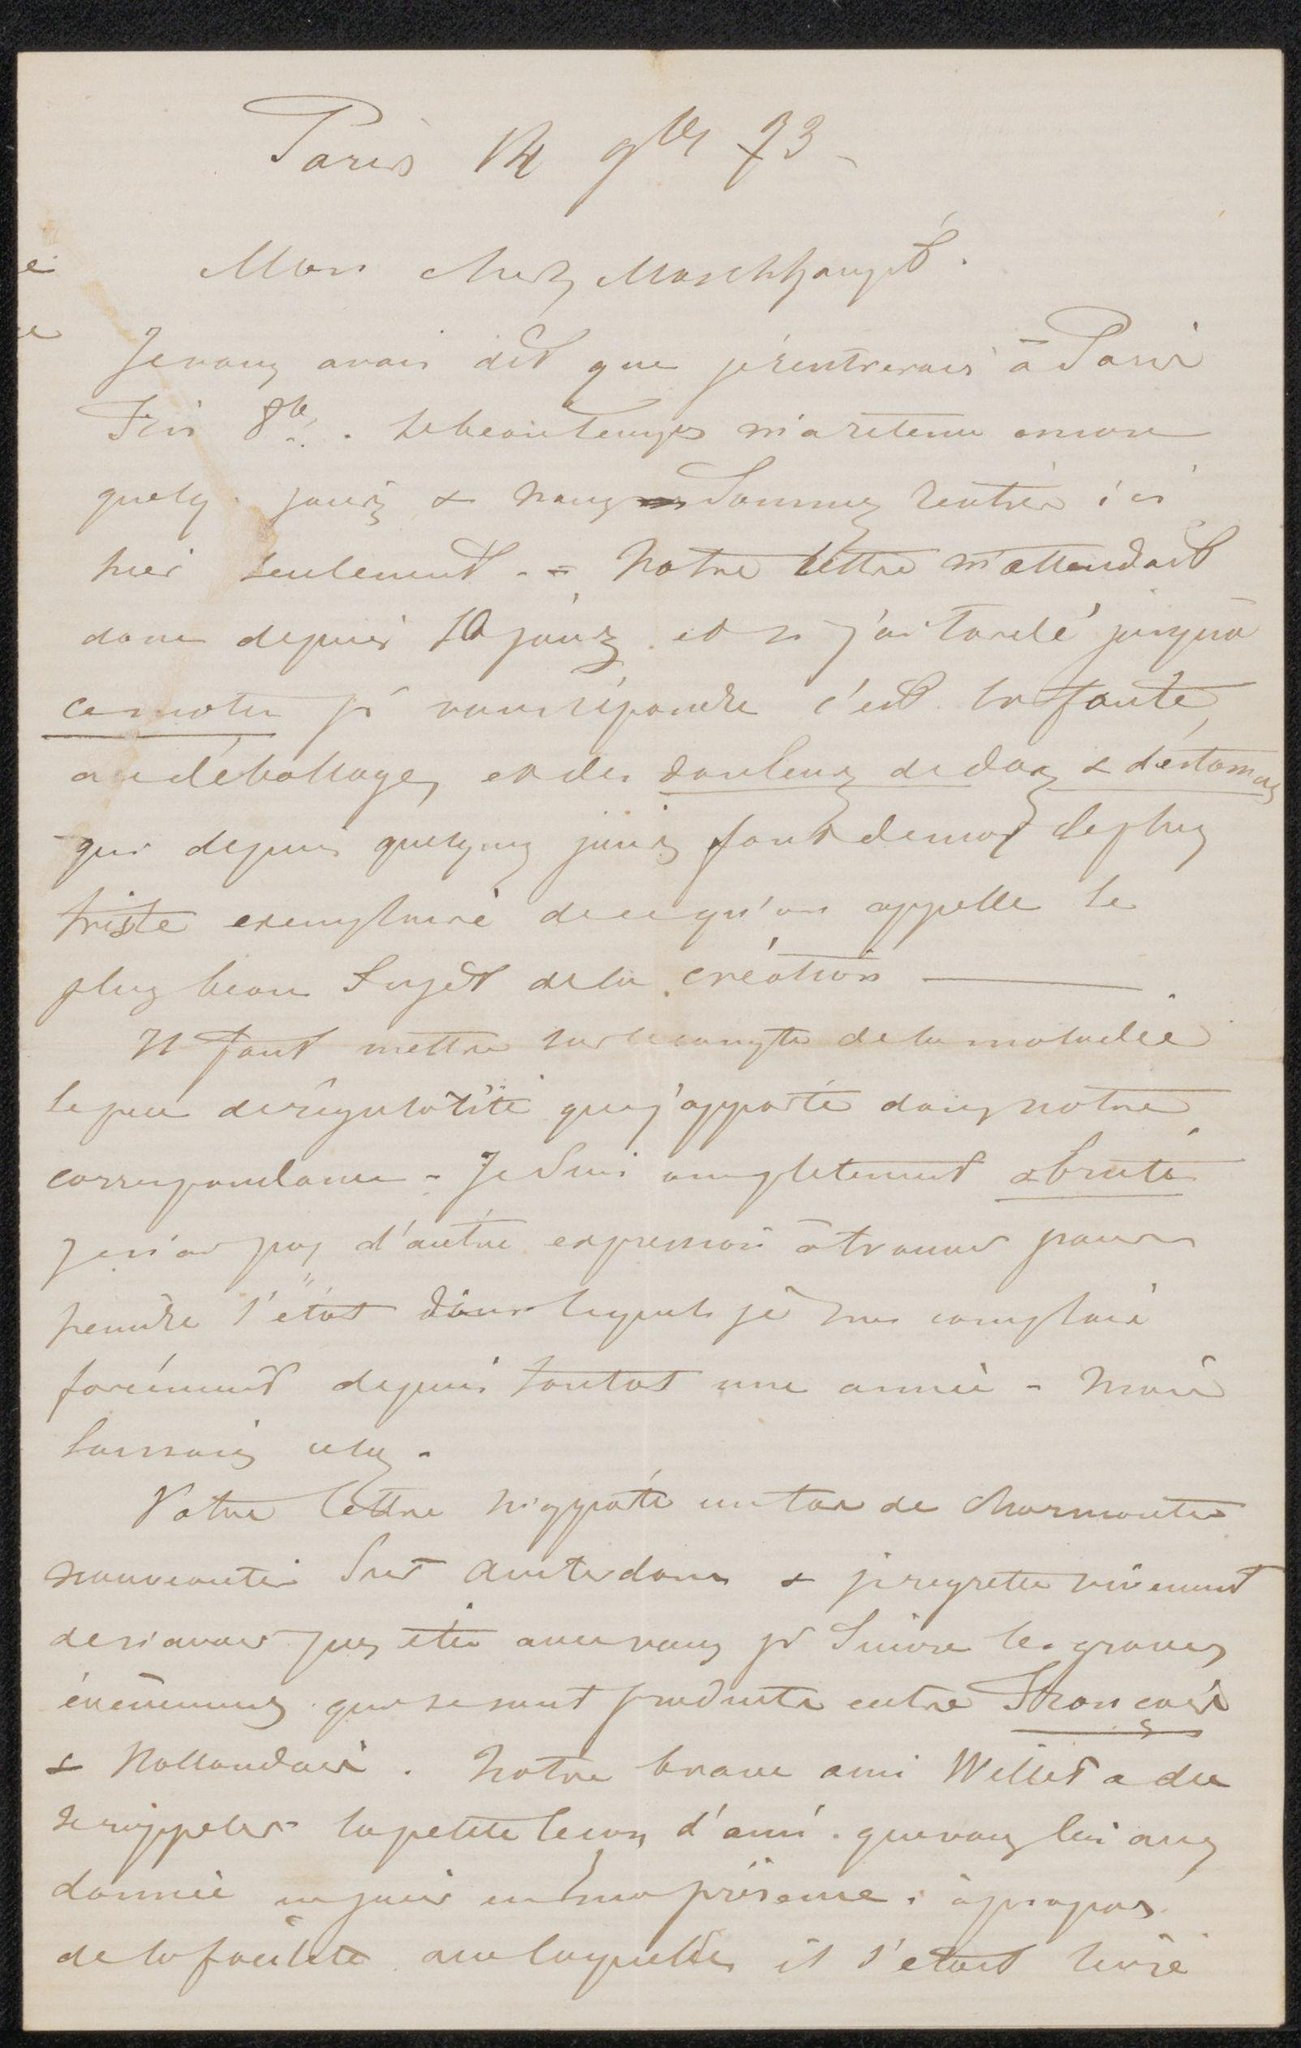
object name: letter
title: Brief aan Jan Hendrik Maschaupt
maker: adolphe mouilleron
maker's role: draughtsman, print maker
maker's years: 1820-1881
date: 1873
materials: ink, paper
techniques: pen, writing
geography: paris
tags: andrzej graaf mniszech, jan hendrik maschaupt, haarlem, frans hals, leiden, amsterdam, painter, print maker, draughtsman, rembrandt van rijn, paris, daniël franken dzn., charles blanc, painting (including book-illumination, miniature-painting)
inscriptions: collector's mark: ‘RPK’